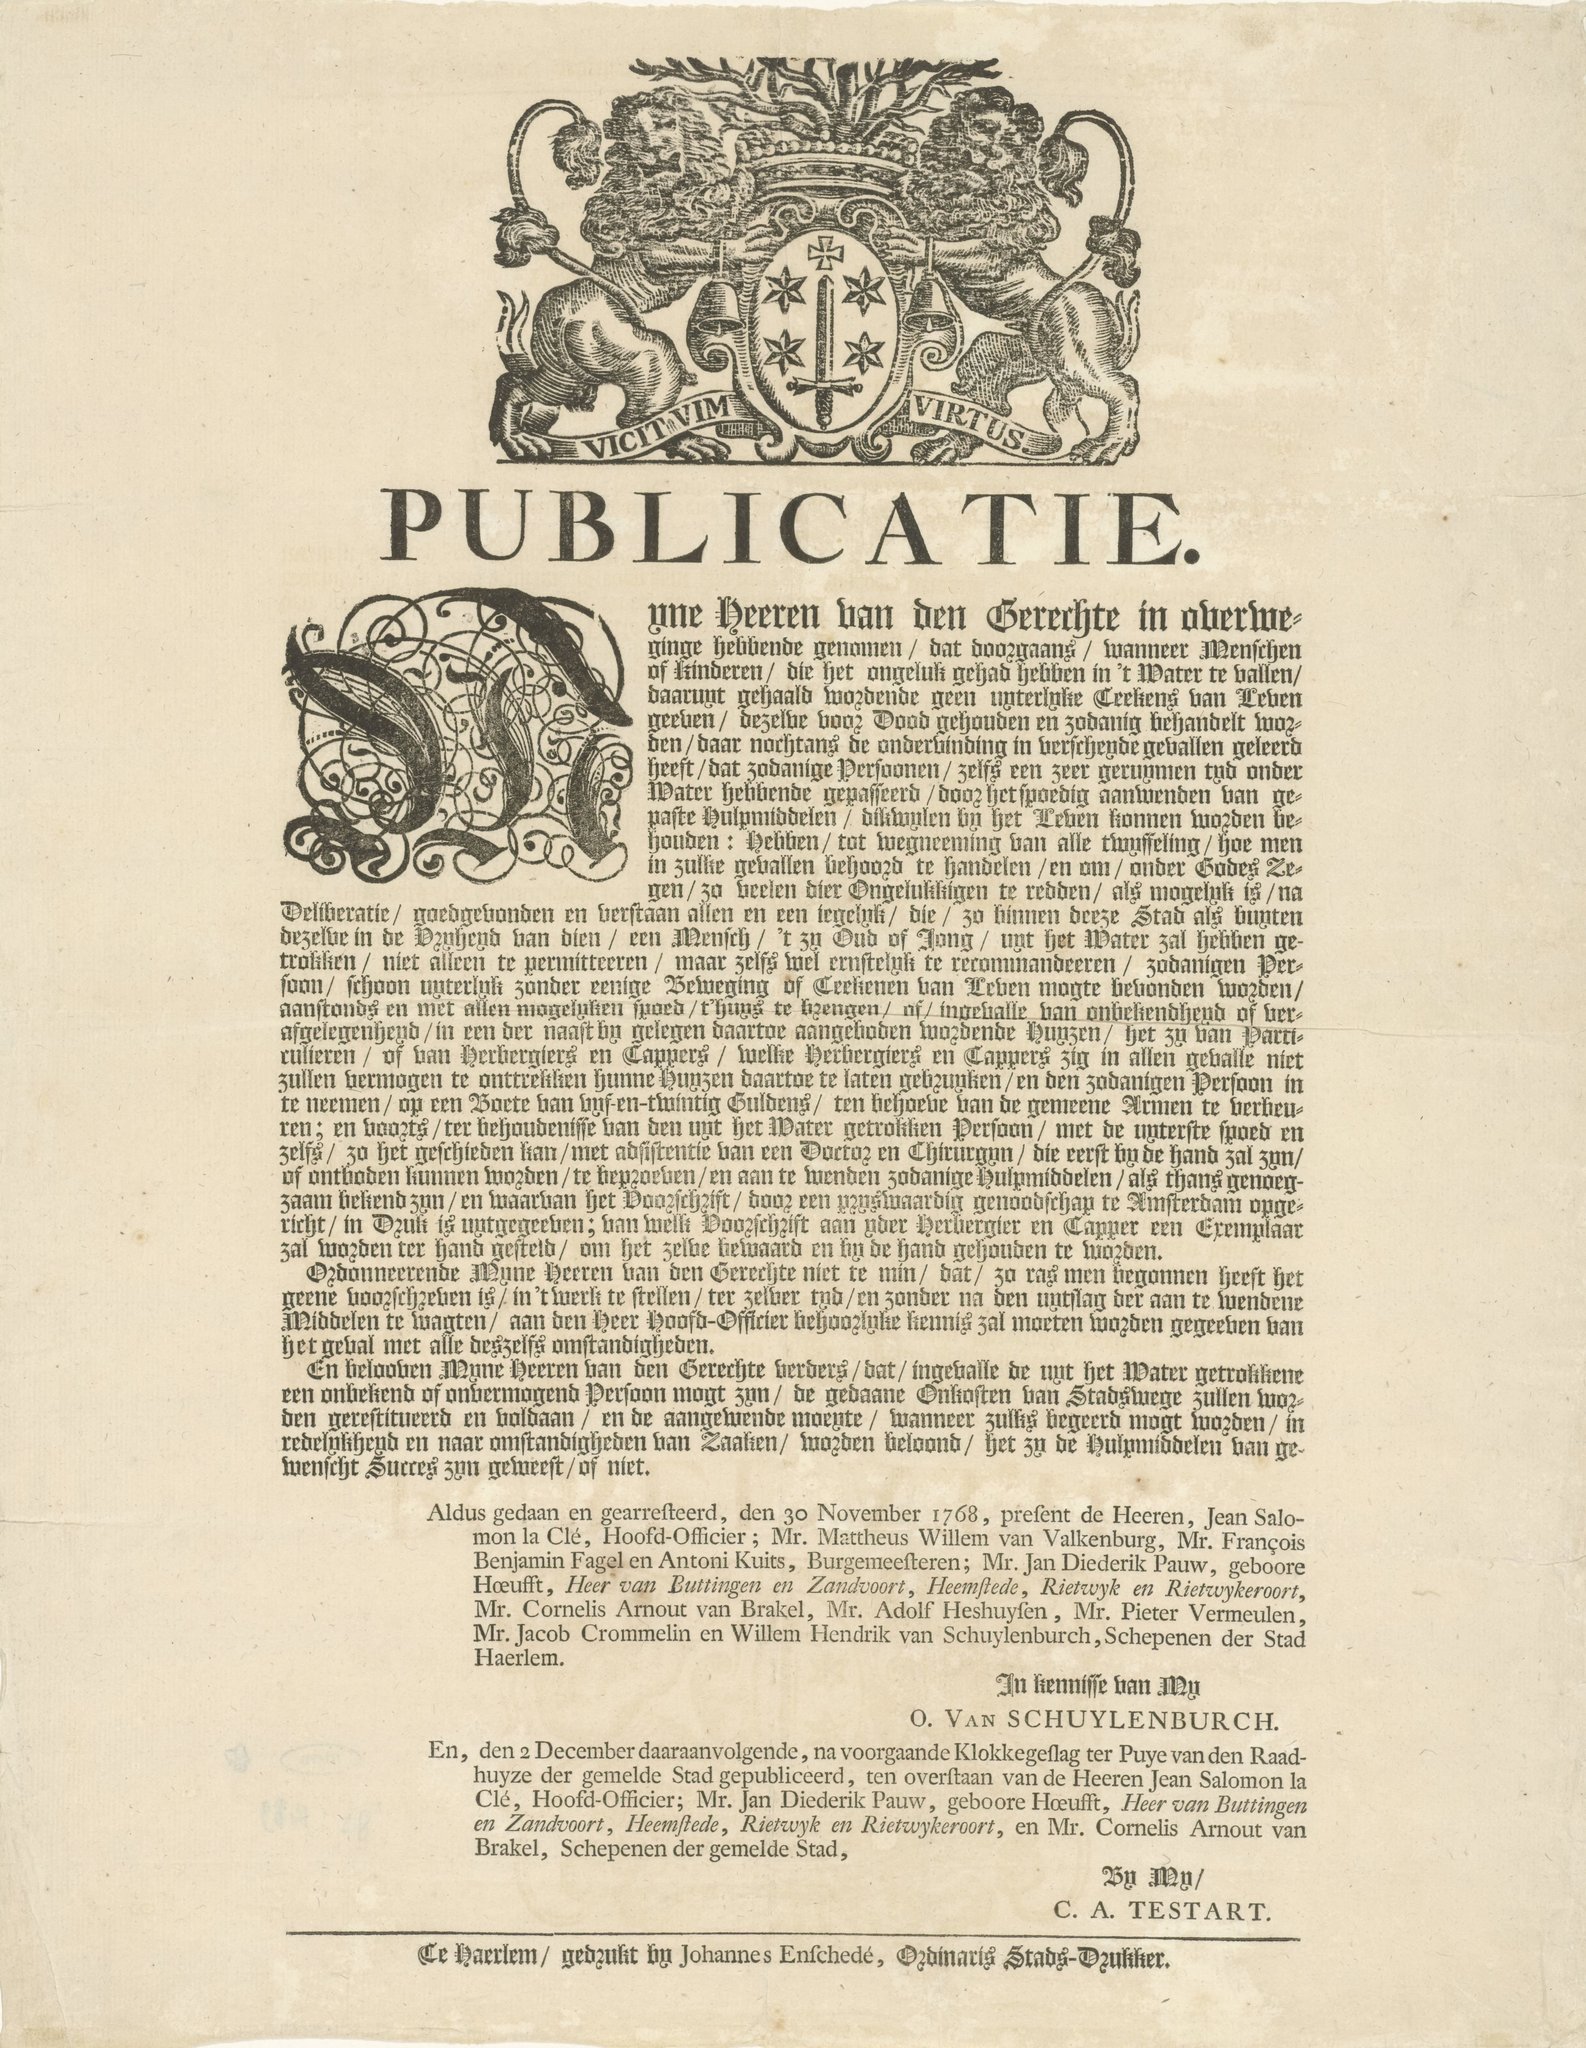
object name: text sheet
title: Publicatie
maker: johannes enschedé (i)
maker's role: print maker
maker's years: 1708-1780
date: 1768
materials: paper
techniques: letterpress printing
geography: haarlem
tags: haarlem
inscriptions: collector's mark: Lugt 2228, collector's mark: Lugt 2760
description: Tekstblad met publicatie over het verlenen van hulp bij personen die te water zijn geraakt, bekendmaking namens het gerecht te Haarlem, 30 november 1768. De tekst begint met een initiaal M, bovenaan het stadswapen van Haarlem.